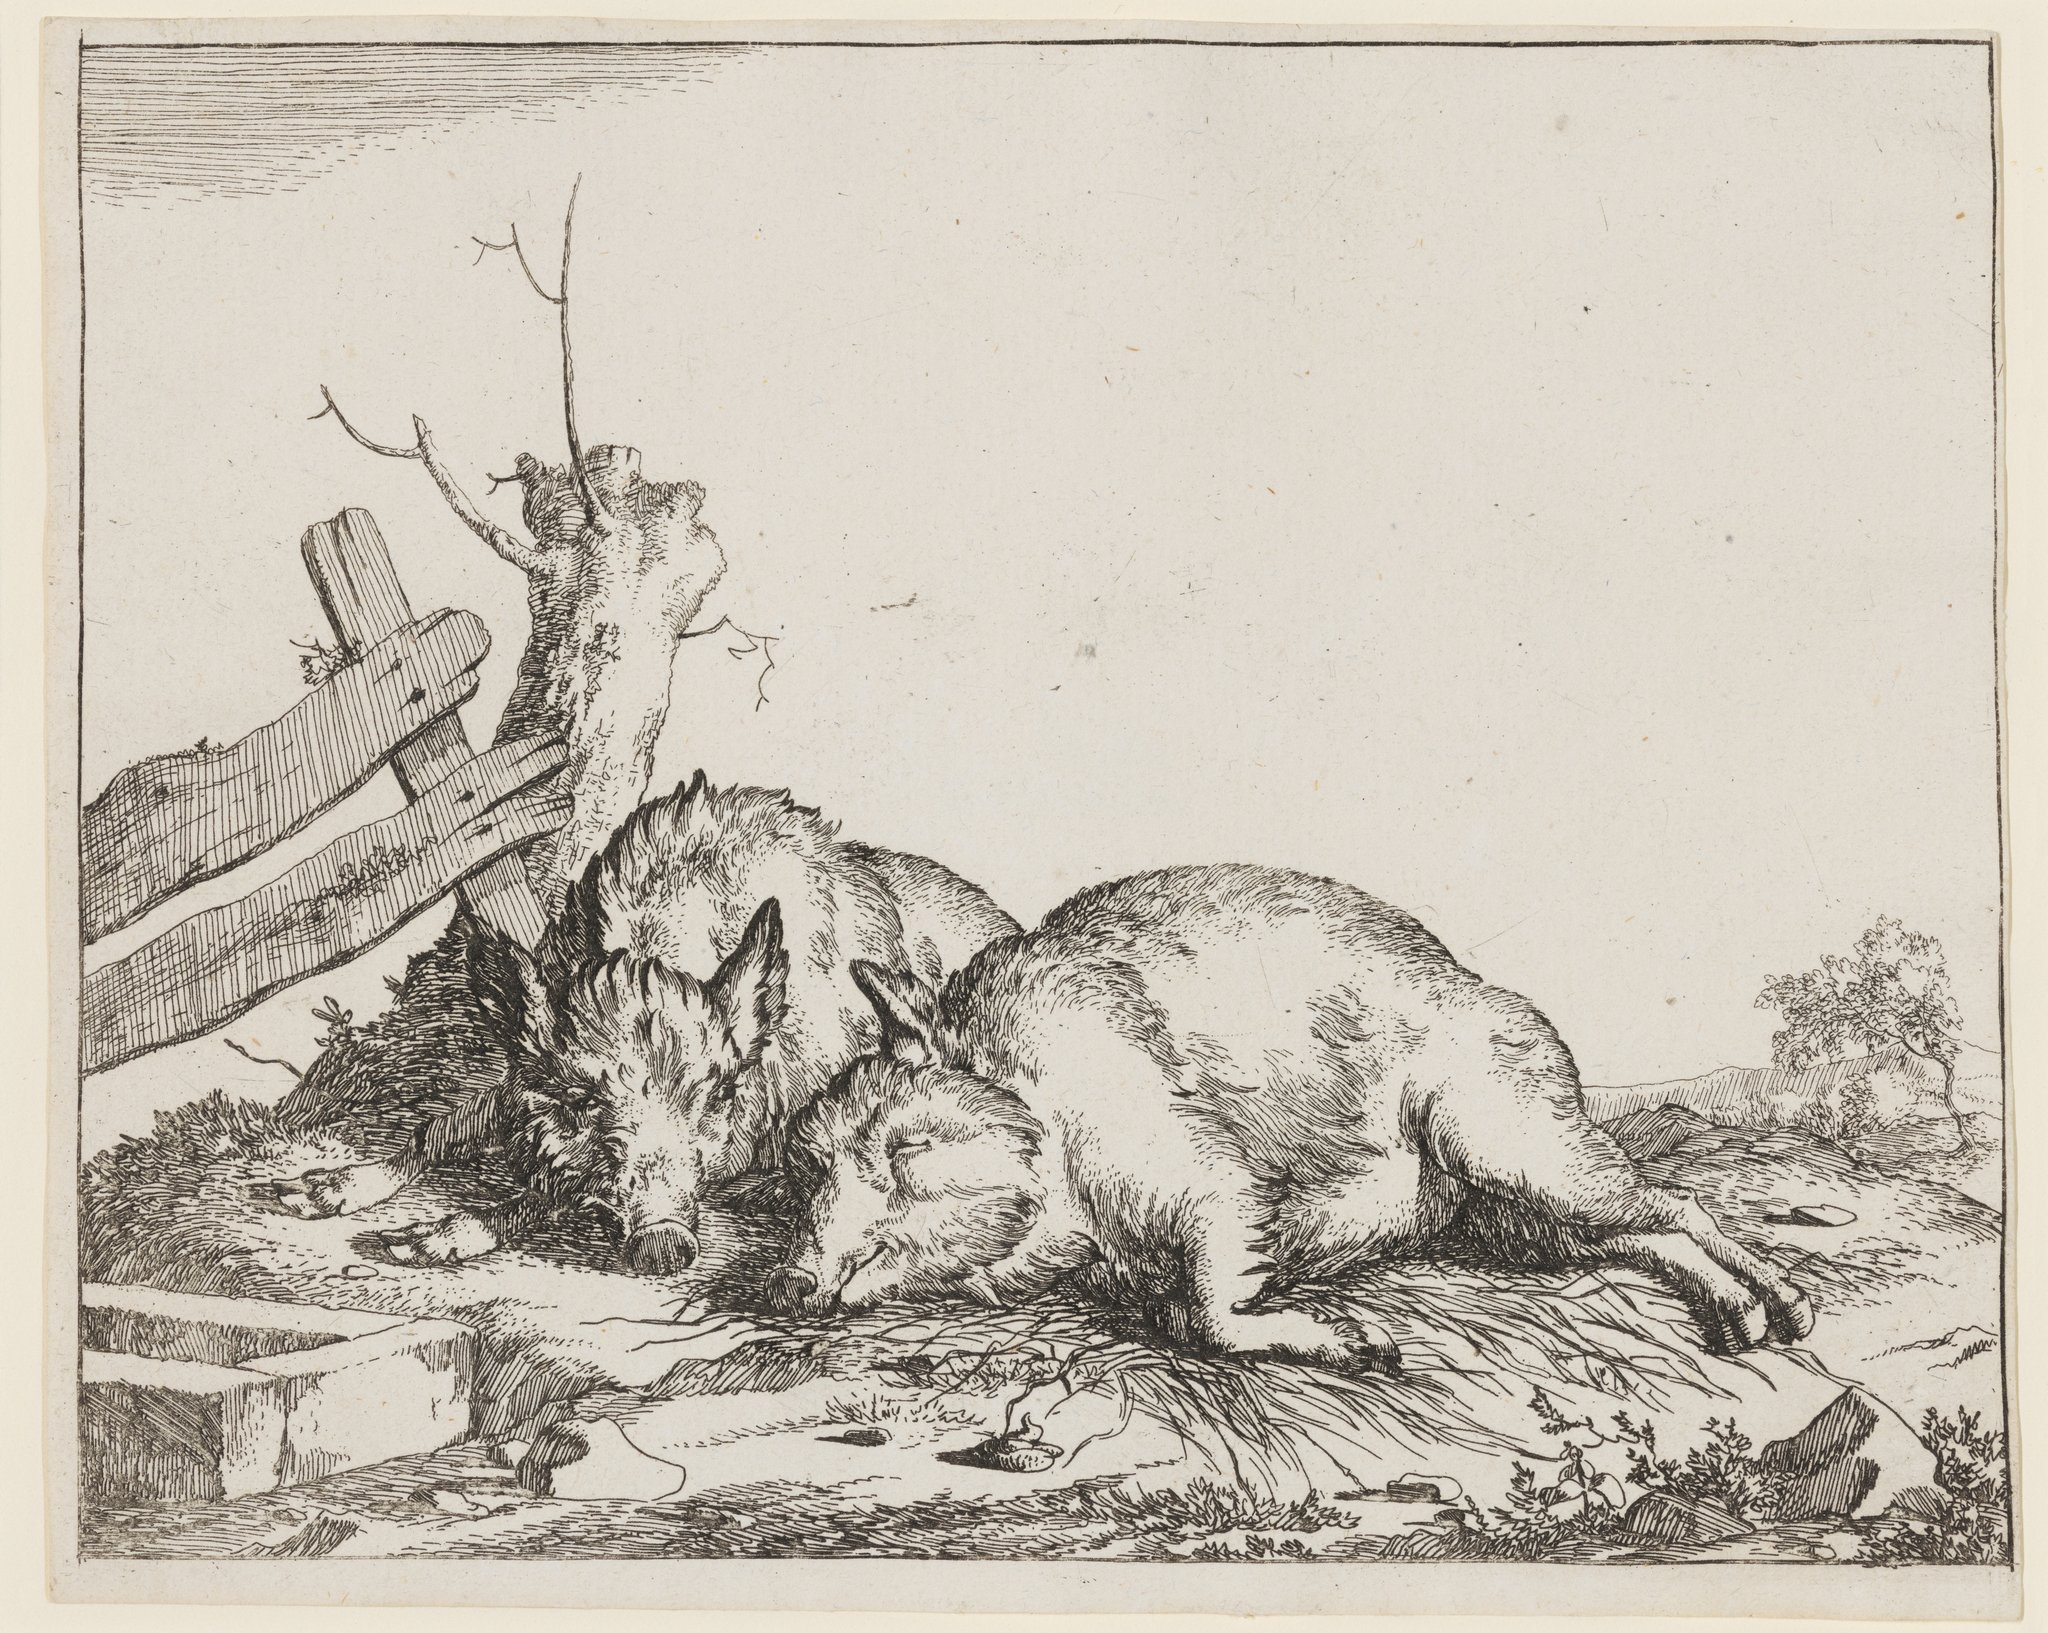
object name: print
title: Two Sleeping Pigs, from "Various Animals"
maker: marcus de bye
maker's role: artist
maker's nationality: dutch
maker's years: 1639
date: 1659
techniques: etching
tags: pigs